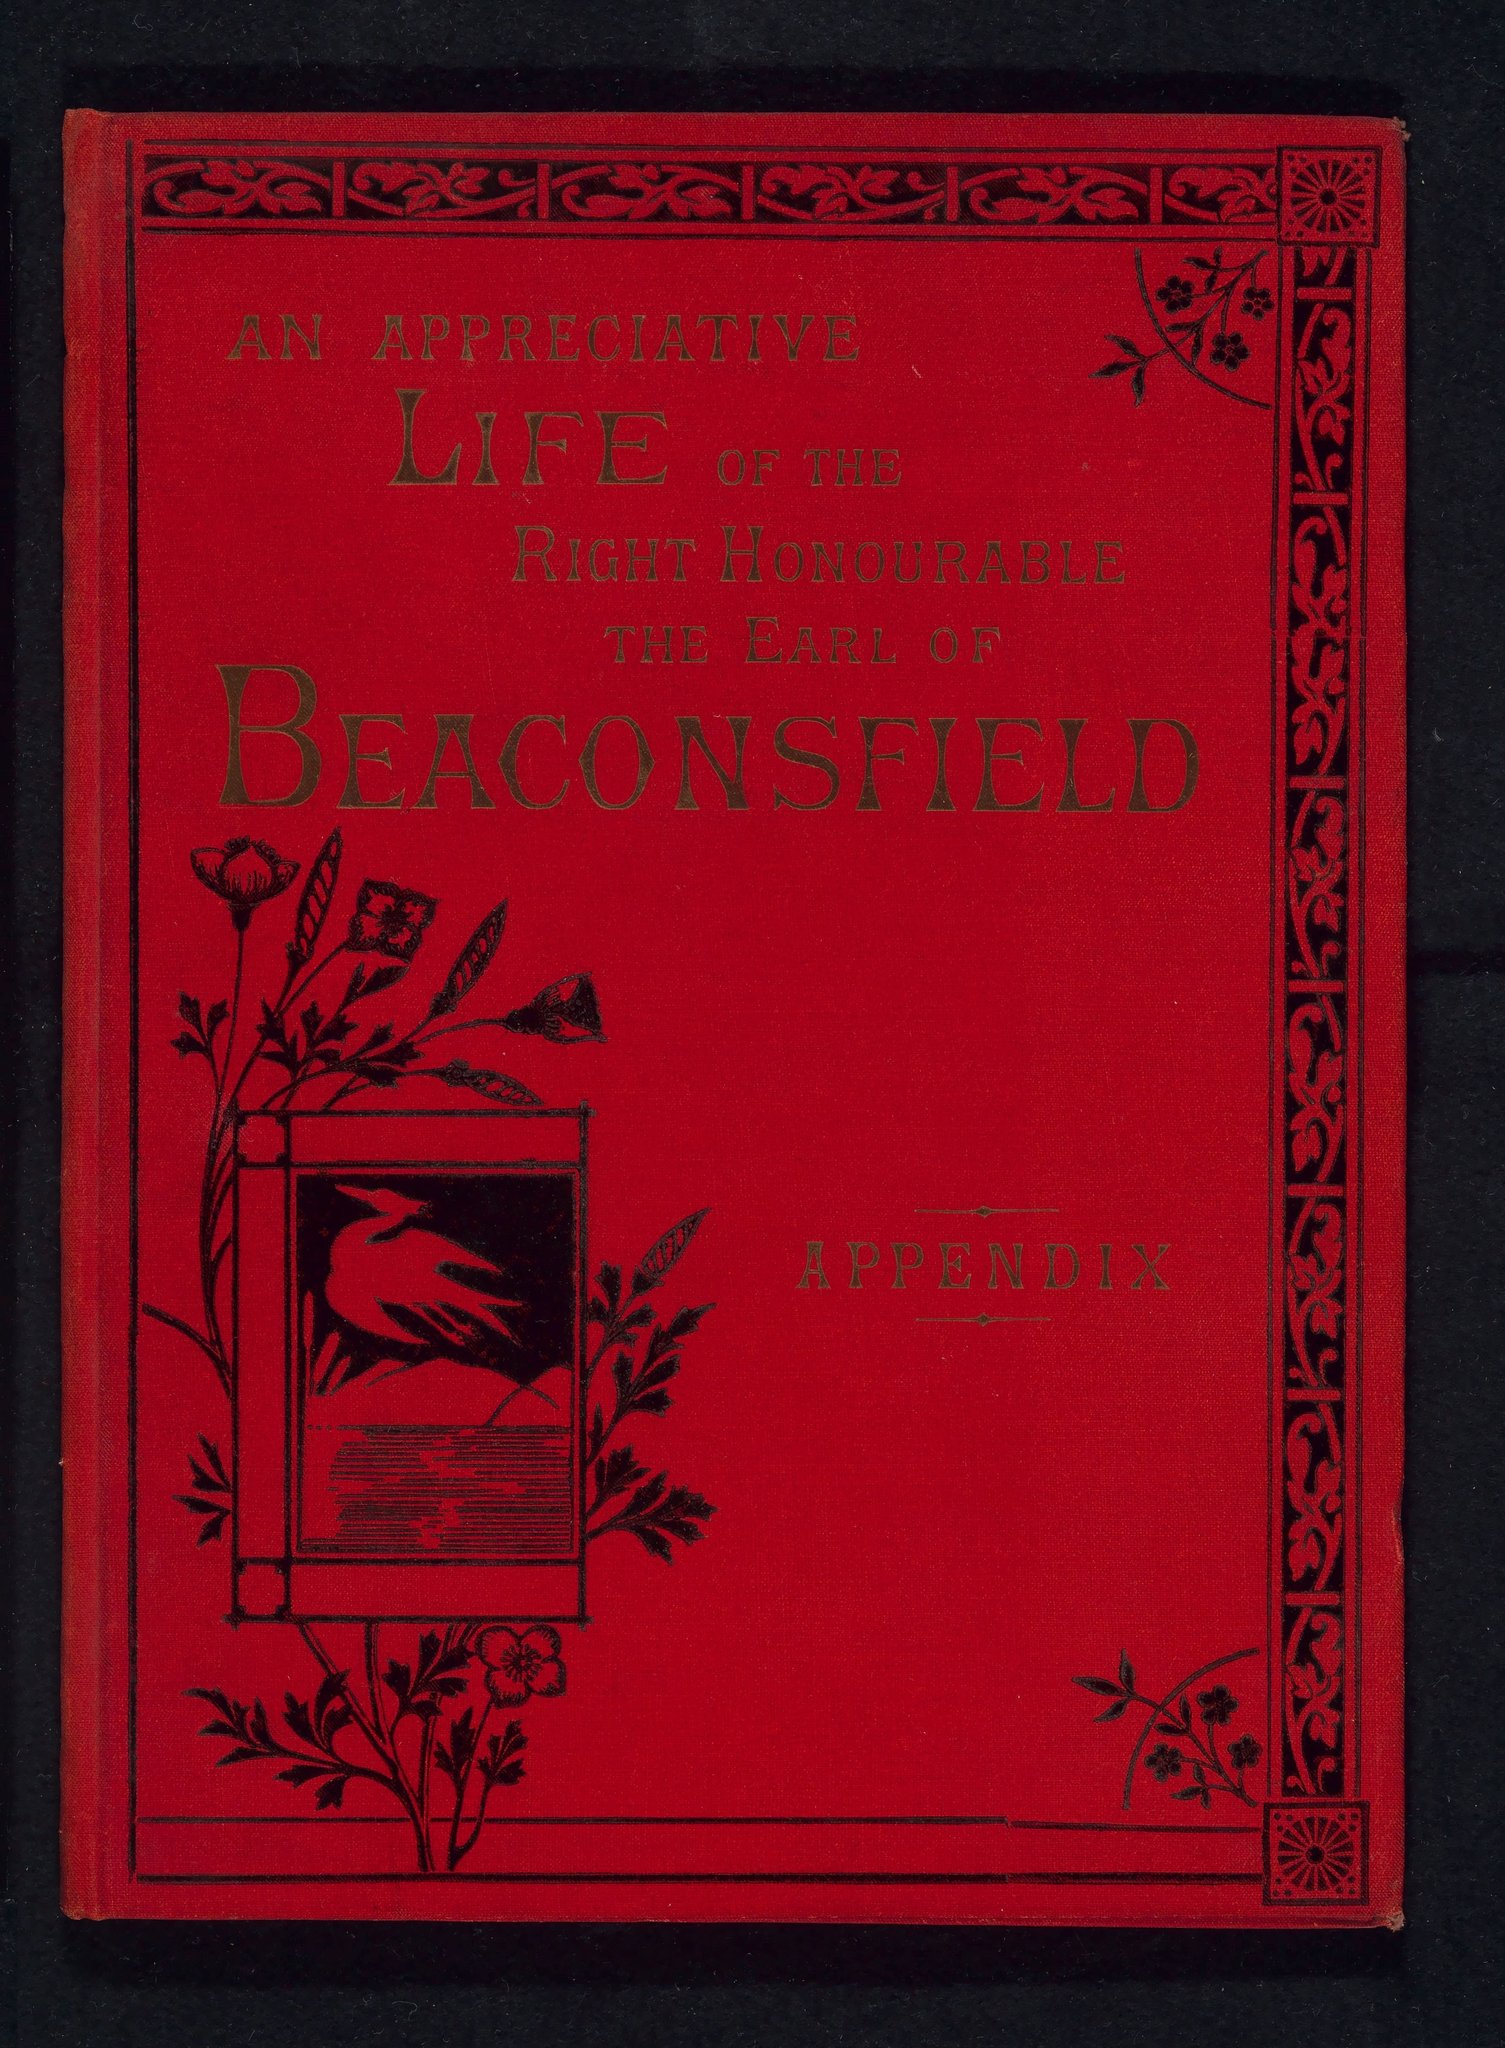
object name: book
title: An appreciative life of the Right. Hon. Earl of Beaconsfield, a statesman of Light and Leading appendix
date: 1881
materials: cardboard, linen, paper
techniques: printing, woodburytype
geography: nottingham